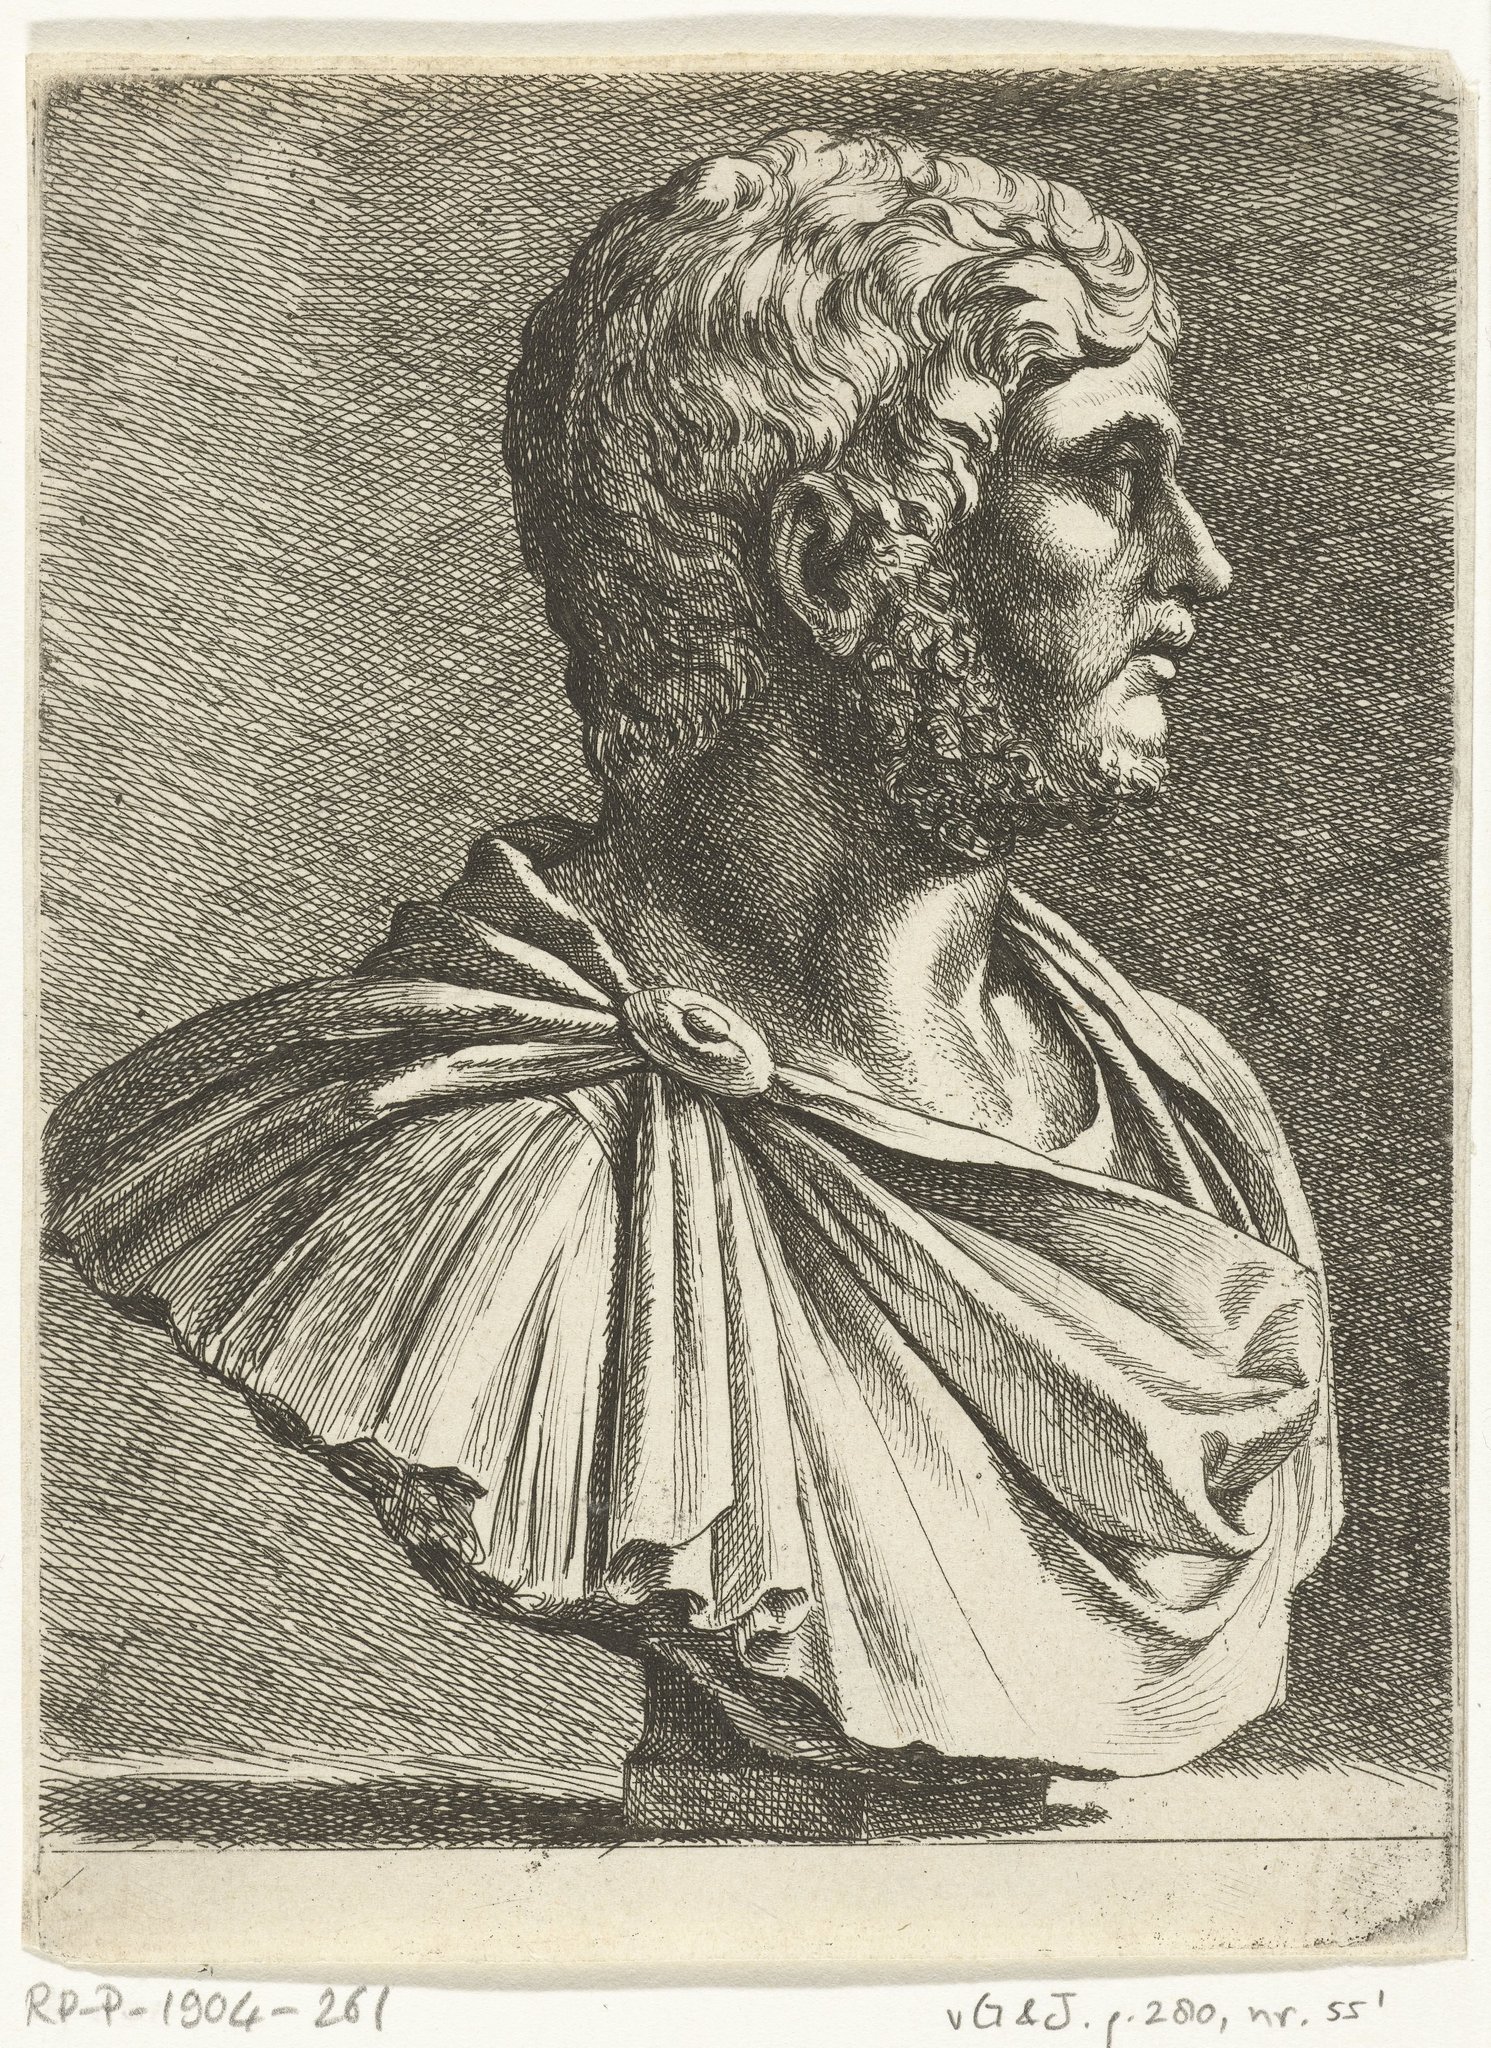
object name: print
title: Portretbuste van keizer Gallienus (?)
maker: jan de bisschop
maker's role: draughtsman, print maker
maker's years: 1628-1671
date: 1666-1671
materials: paper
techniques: etching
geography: northern netherlands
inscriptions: collector's mark: Lugt 2228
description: afkomstig uit: Paradigmata graphices variorum artificum : voor-beelden der teken-konst van verscheyde meesters, (2e of latere editie)